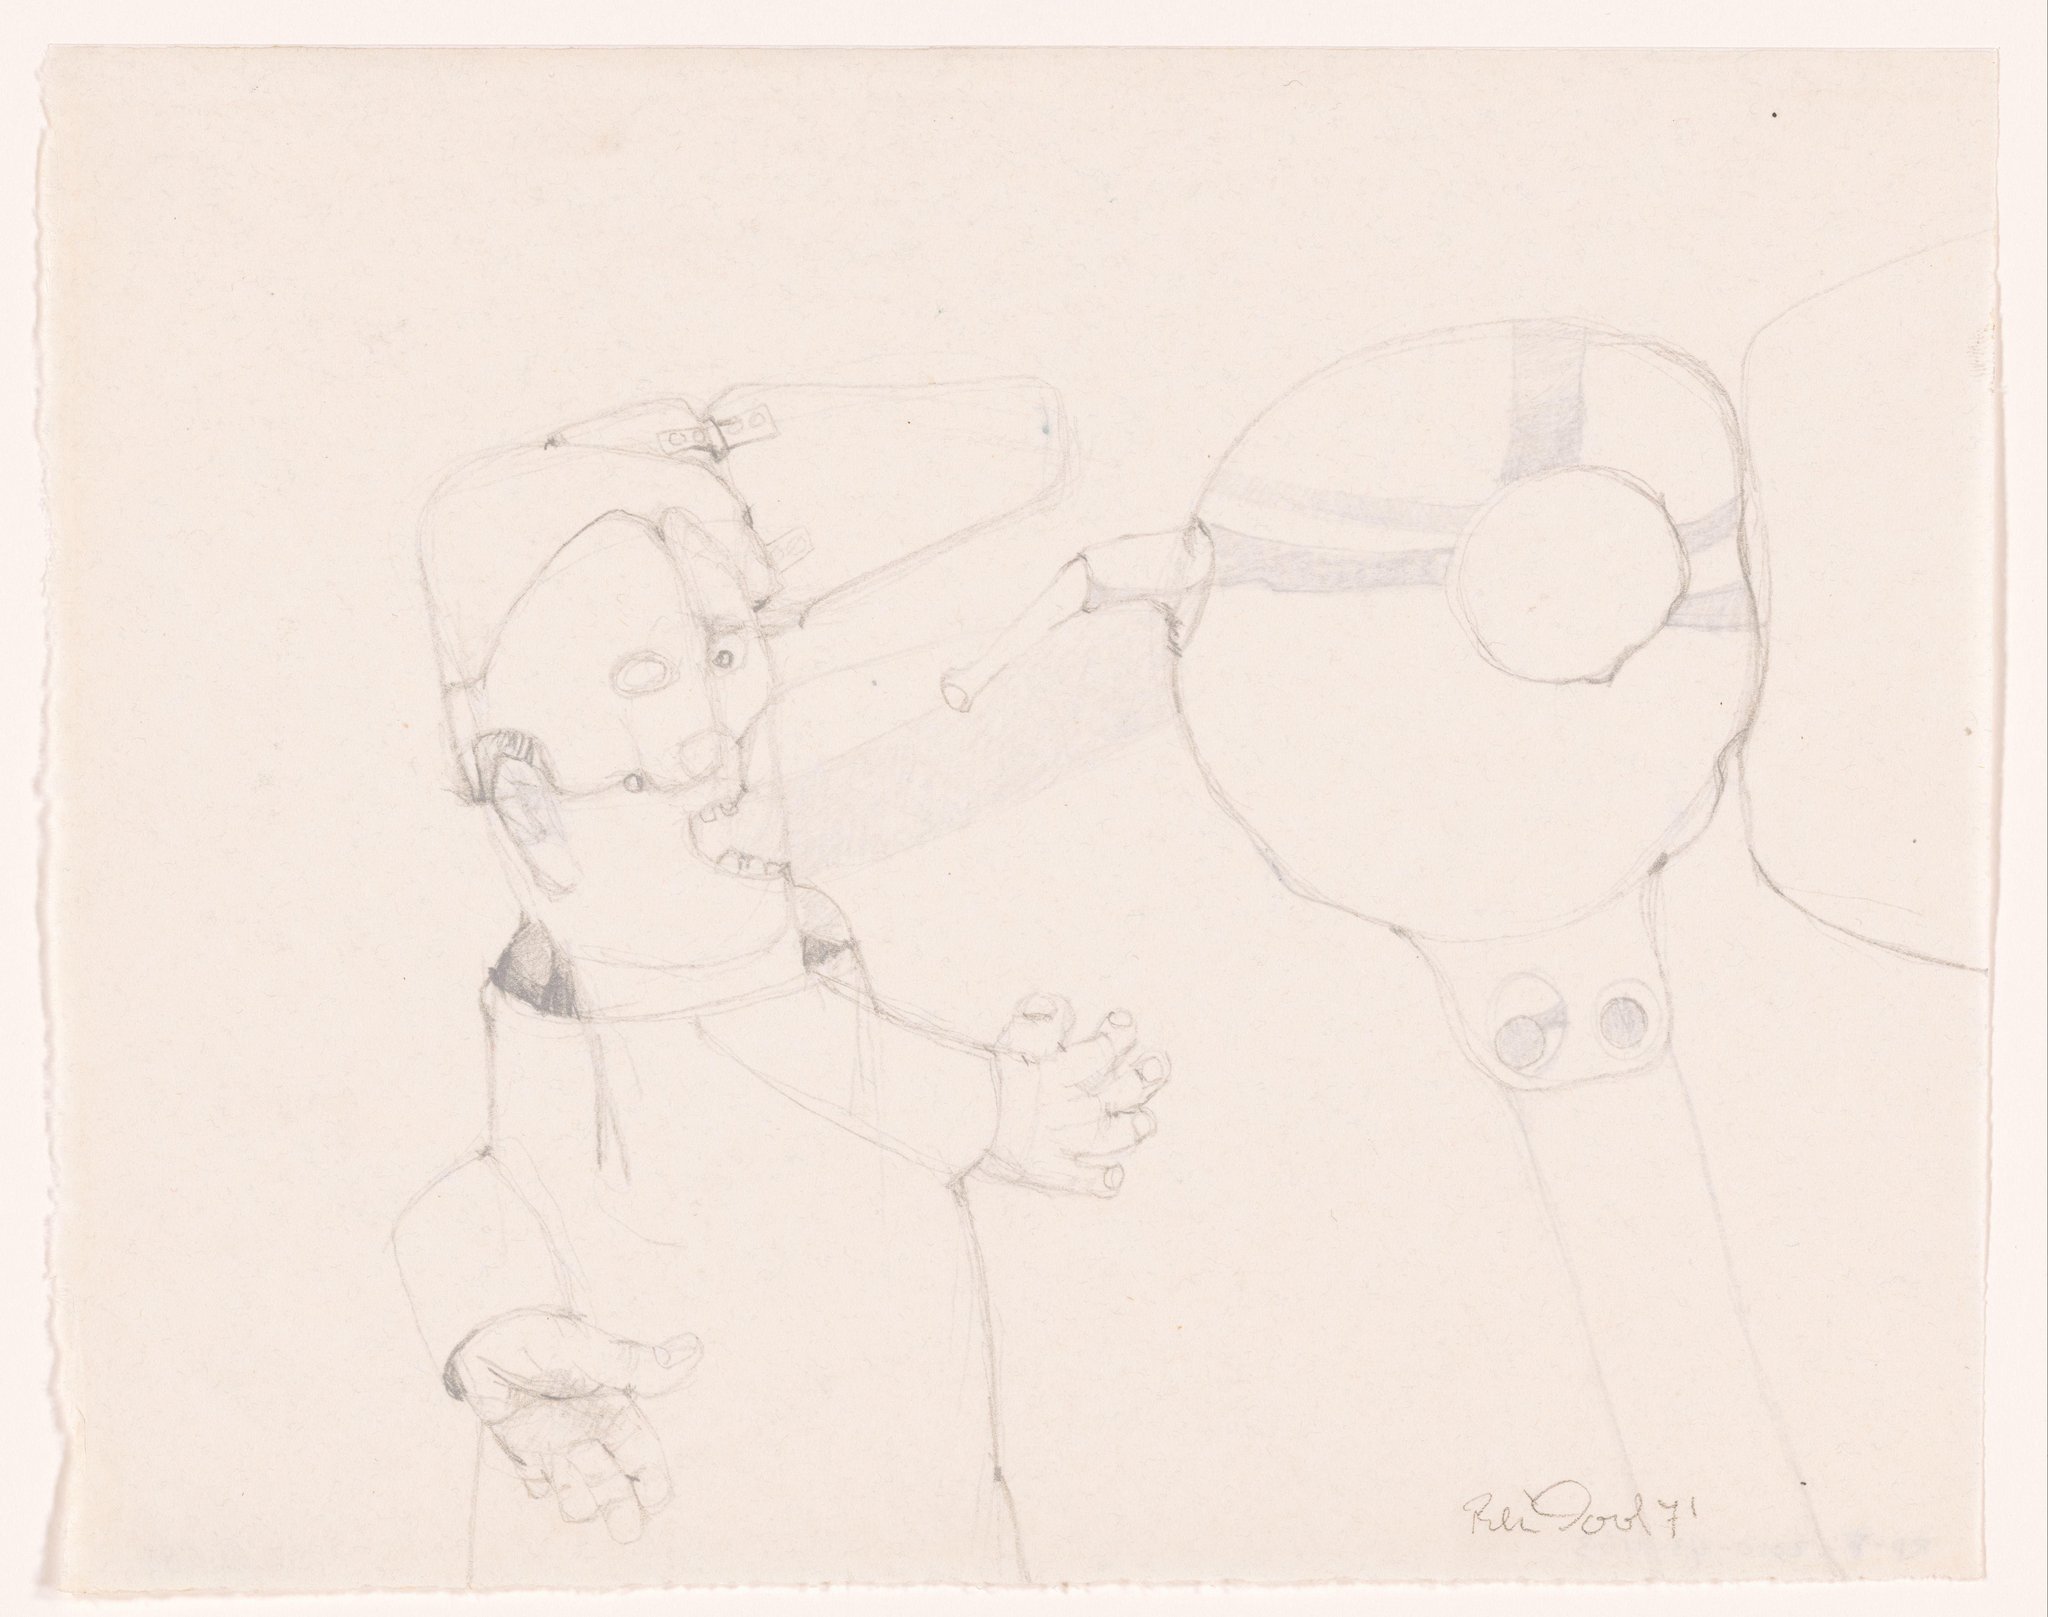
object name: drawing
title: No V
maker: rein dool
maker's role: draughtsman, painter, print maker, sculptor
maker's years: 1933-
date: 1971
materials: paper, pencil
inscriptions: signature and date: ‘Rein Dool 71’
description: Robotachtige man met klepje bij zijn hoofd, geopende mond en cilindervormige armen.